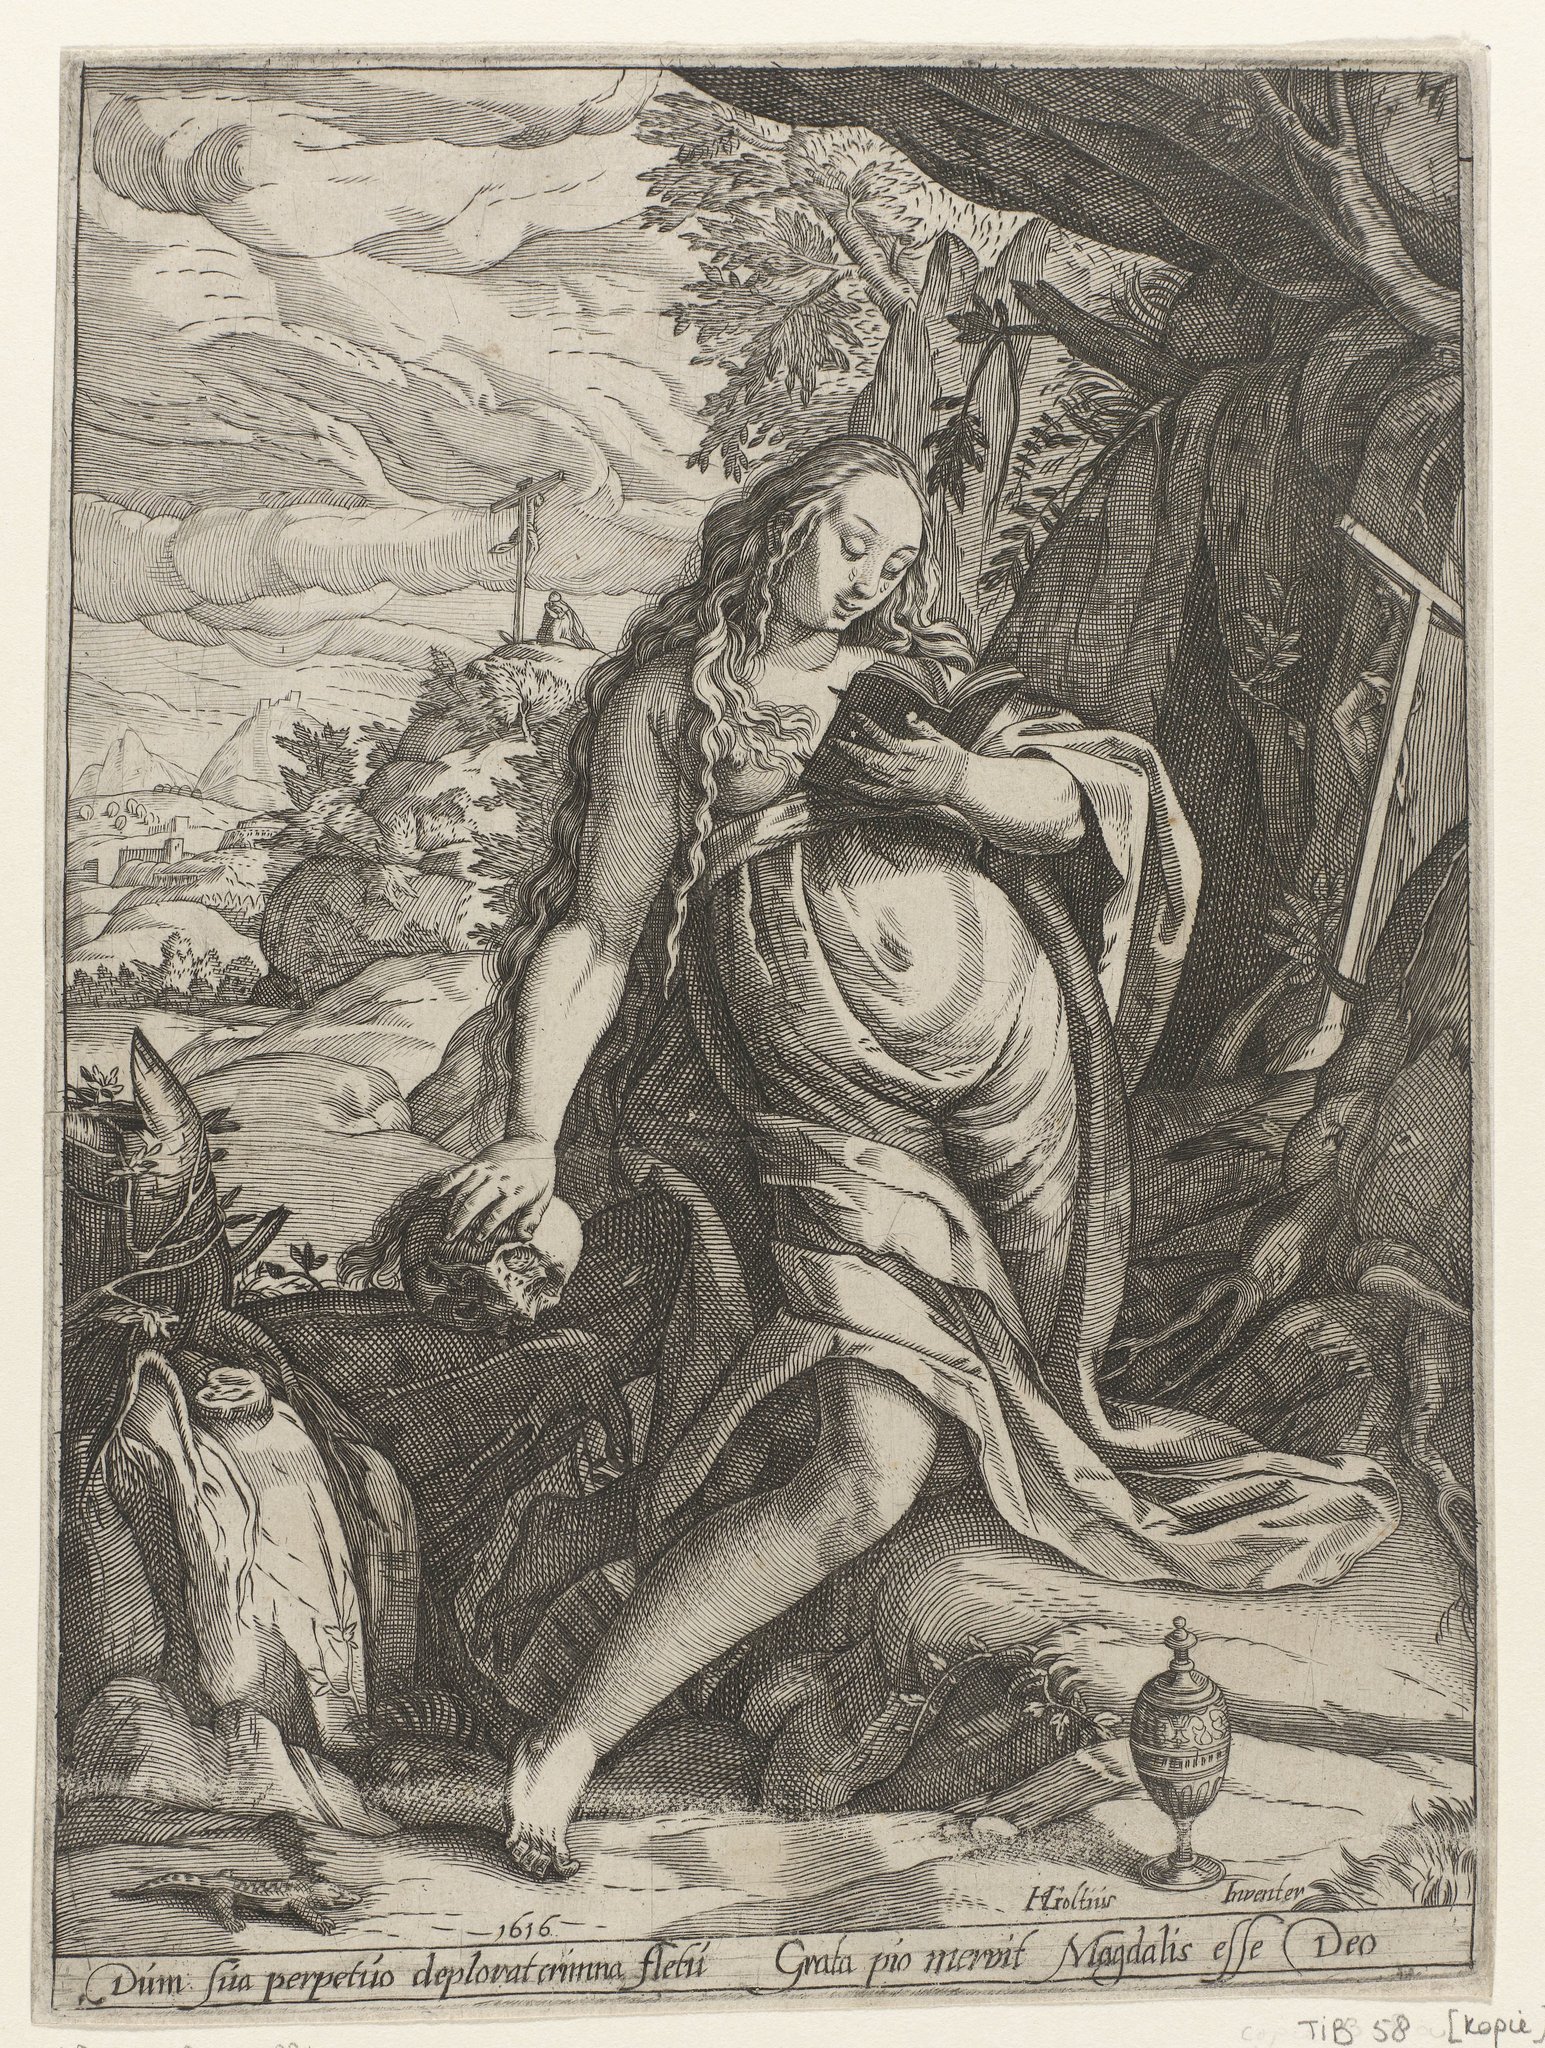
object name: print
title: De boetvaardige Maria Magdalena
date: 1616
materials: paper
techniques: engraving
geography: netherlands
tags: the penitent harlot mary magdalene; possible attributes: book (or scroll), crown, crown of thorns, crucifix, jar of ointment, mirror, musical instrument, palm-branch, rosary, scourge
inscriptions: collector's mark: Lugt 2228a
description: De Heilige Maria Magdalena, ten voeten uit, leunend op een schedel. Op de achtergrond links is Maria Magdalena nogmaals te zien, geknield onder Christus aan het kruis. Regel Latijn in marge onder prent.